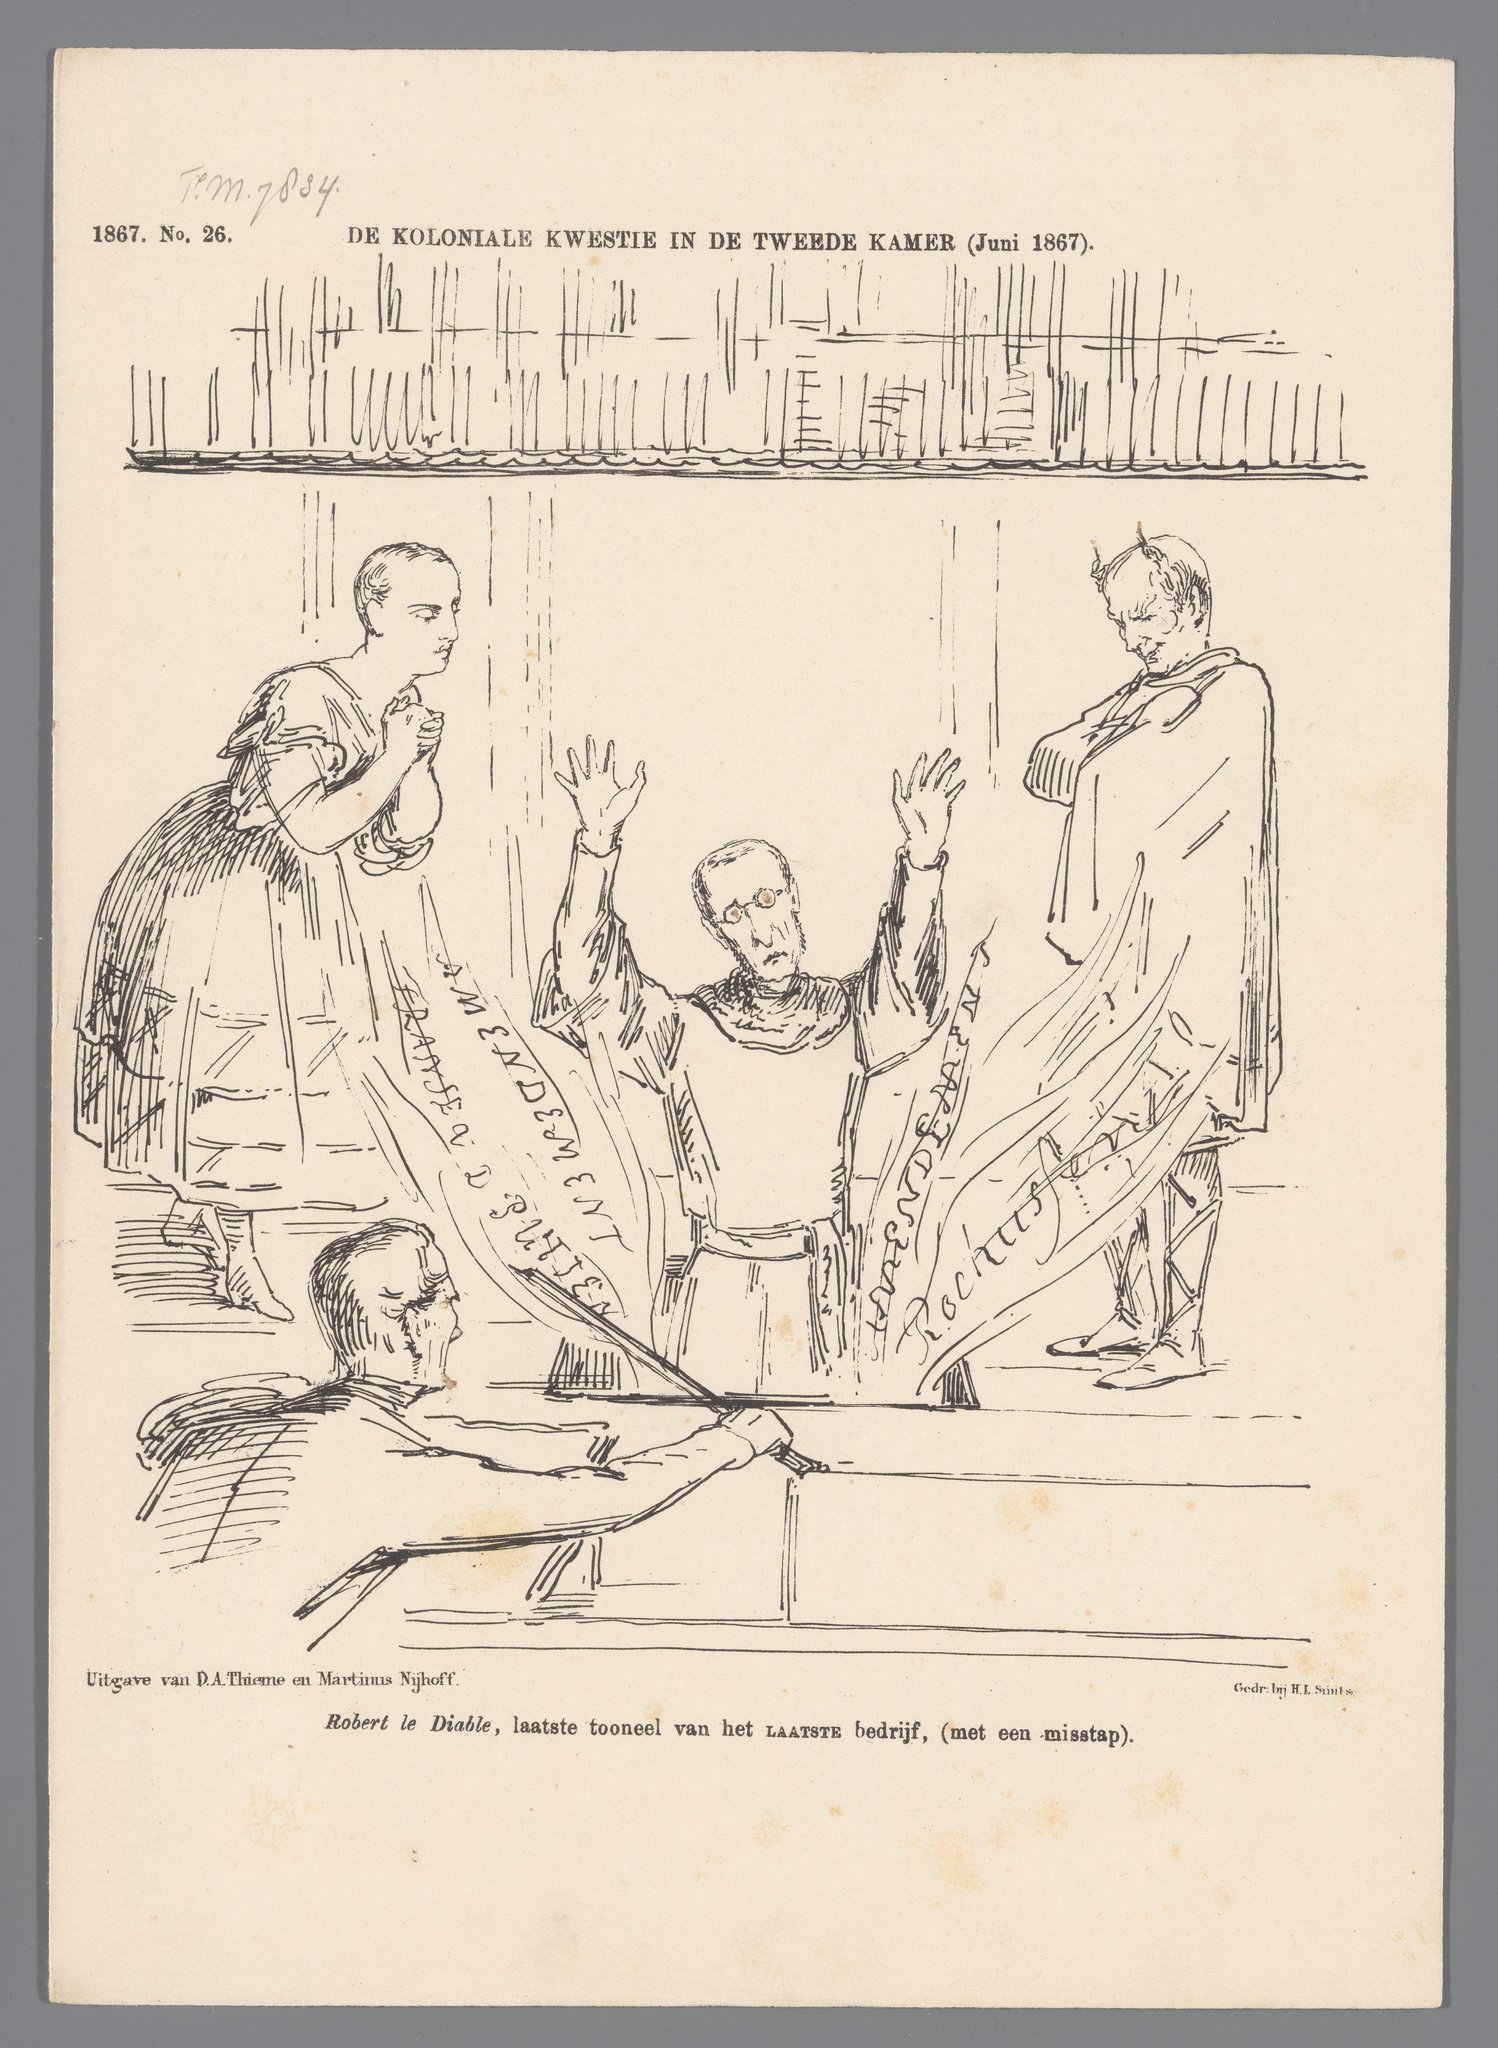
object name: print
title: Spotprent over Trakranen en de koloniale kwestie (plaat 2), 1867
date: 1867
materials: paper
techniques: lithograph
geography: netherlands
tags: johan rudolf thorbecke, theatre, theatrical performance, dutch east indies, the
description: Spotprent over Trakranen en de koloniale kwestie, voorgesteld als een scène uit 'Robert le Diable'. Trakranen valt in de vlammen van de amendementen. Thorbecke is orkestmeester. Zie ook de vorige plaat. Plaat verschenen bij het weekblad De Nederlandsche Spectator, nr. 26, 29 juni 1867.